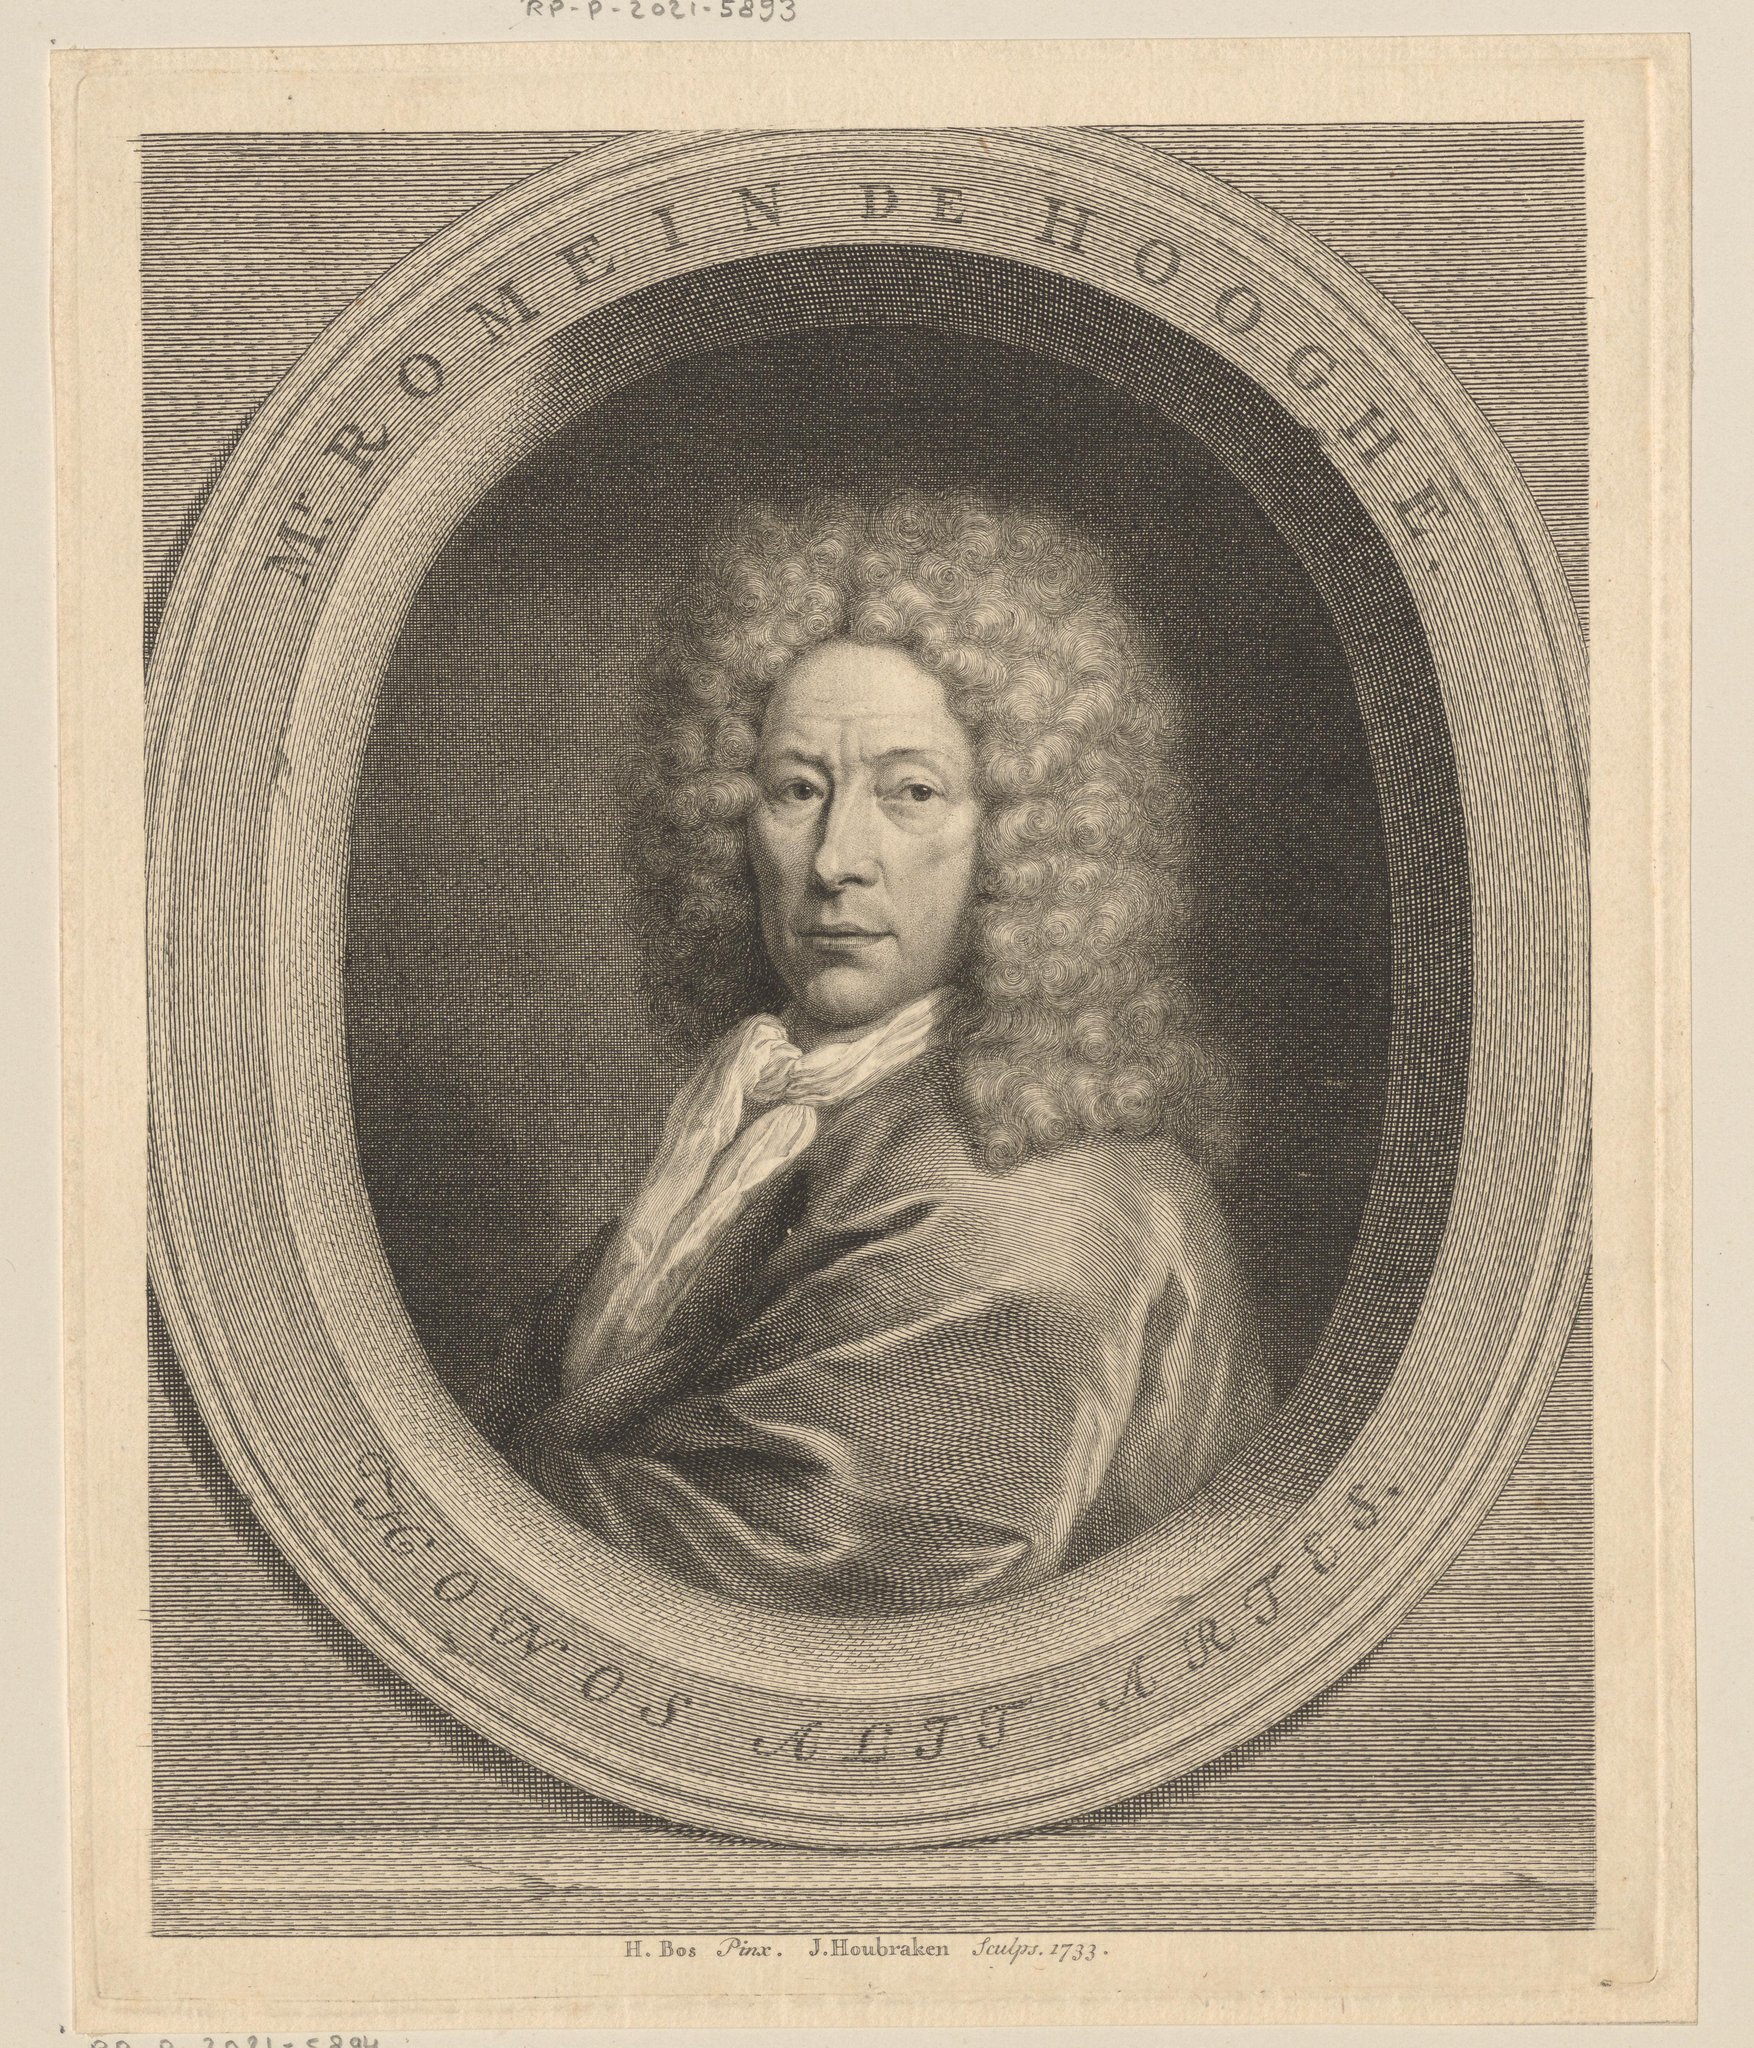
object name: print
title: Portret van Romeyn de Hooghe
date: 1733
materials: paper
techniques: engraving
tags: amsterdam, haarlem, painter, print maker, draughtsman, goldsmith, romeyn de hooghe, historical persons, portrait, self-portrait of graphic artist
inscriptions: collector's mark: Lugt 963